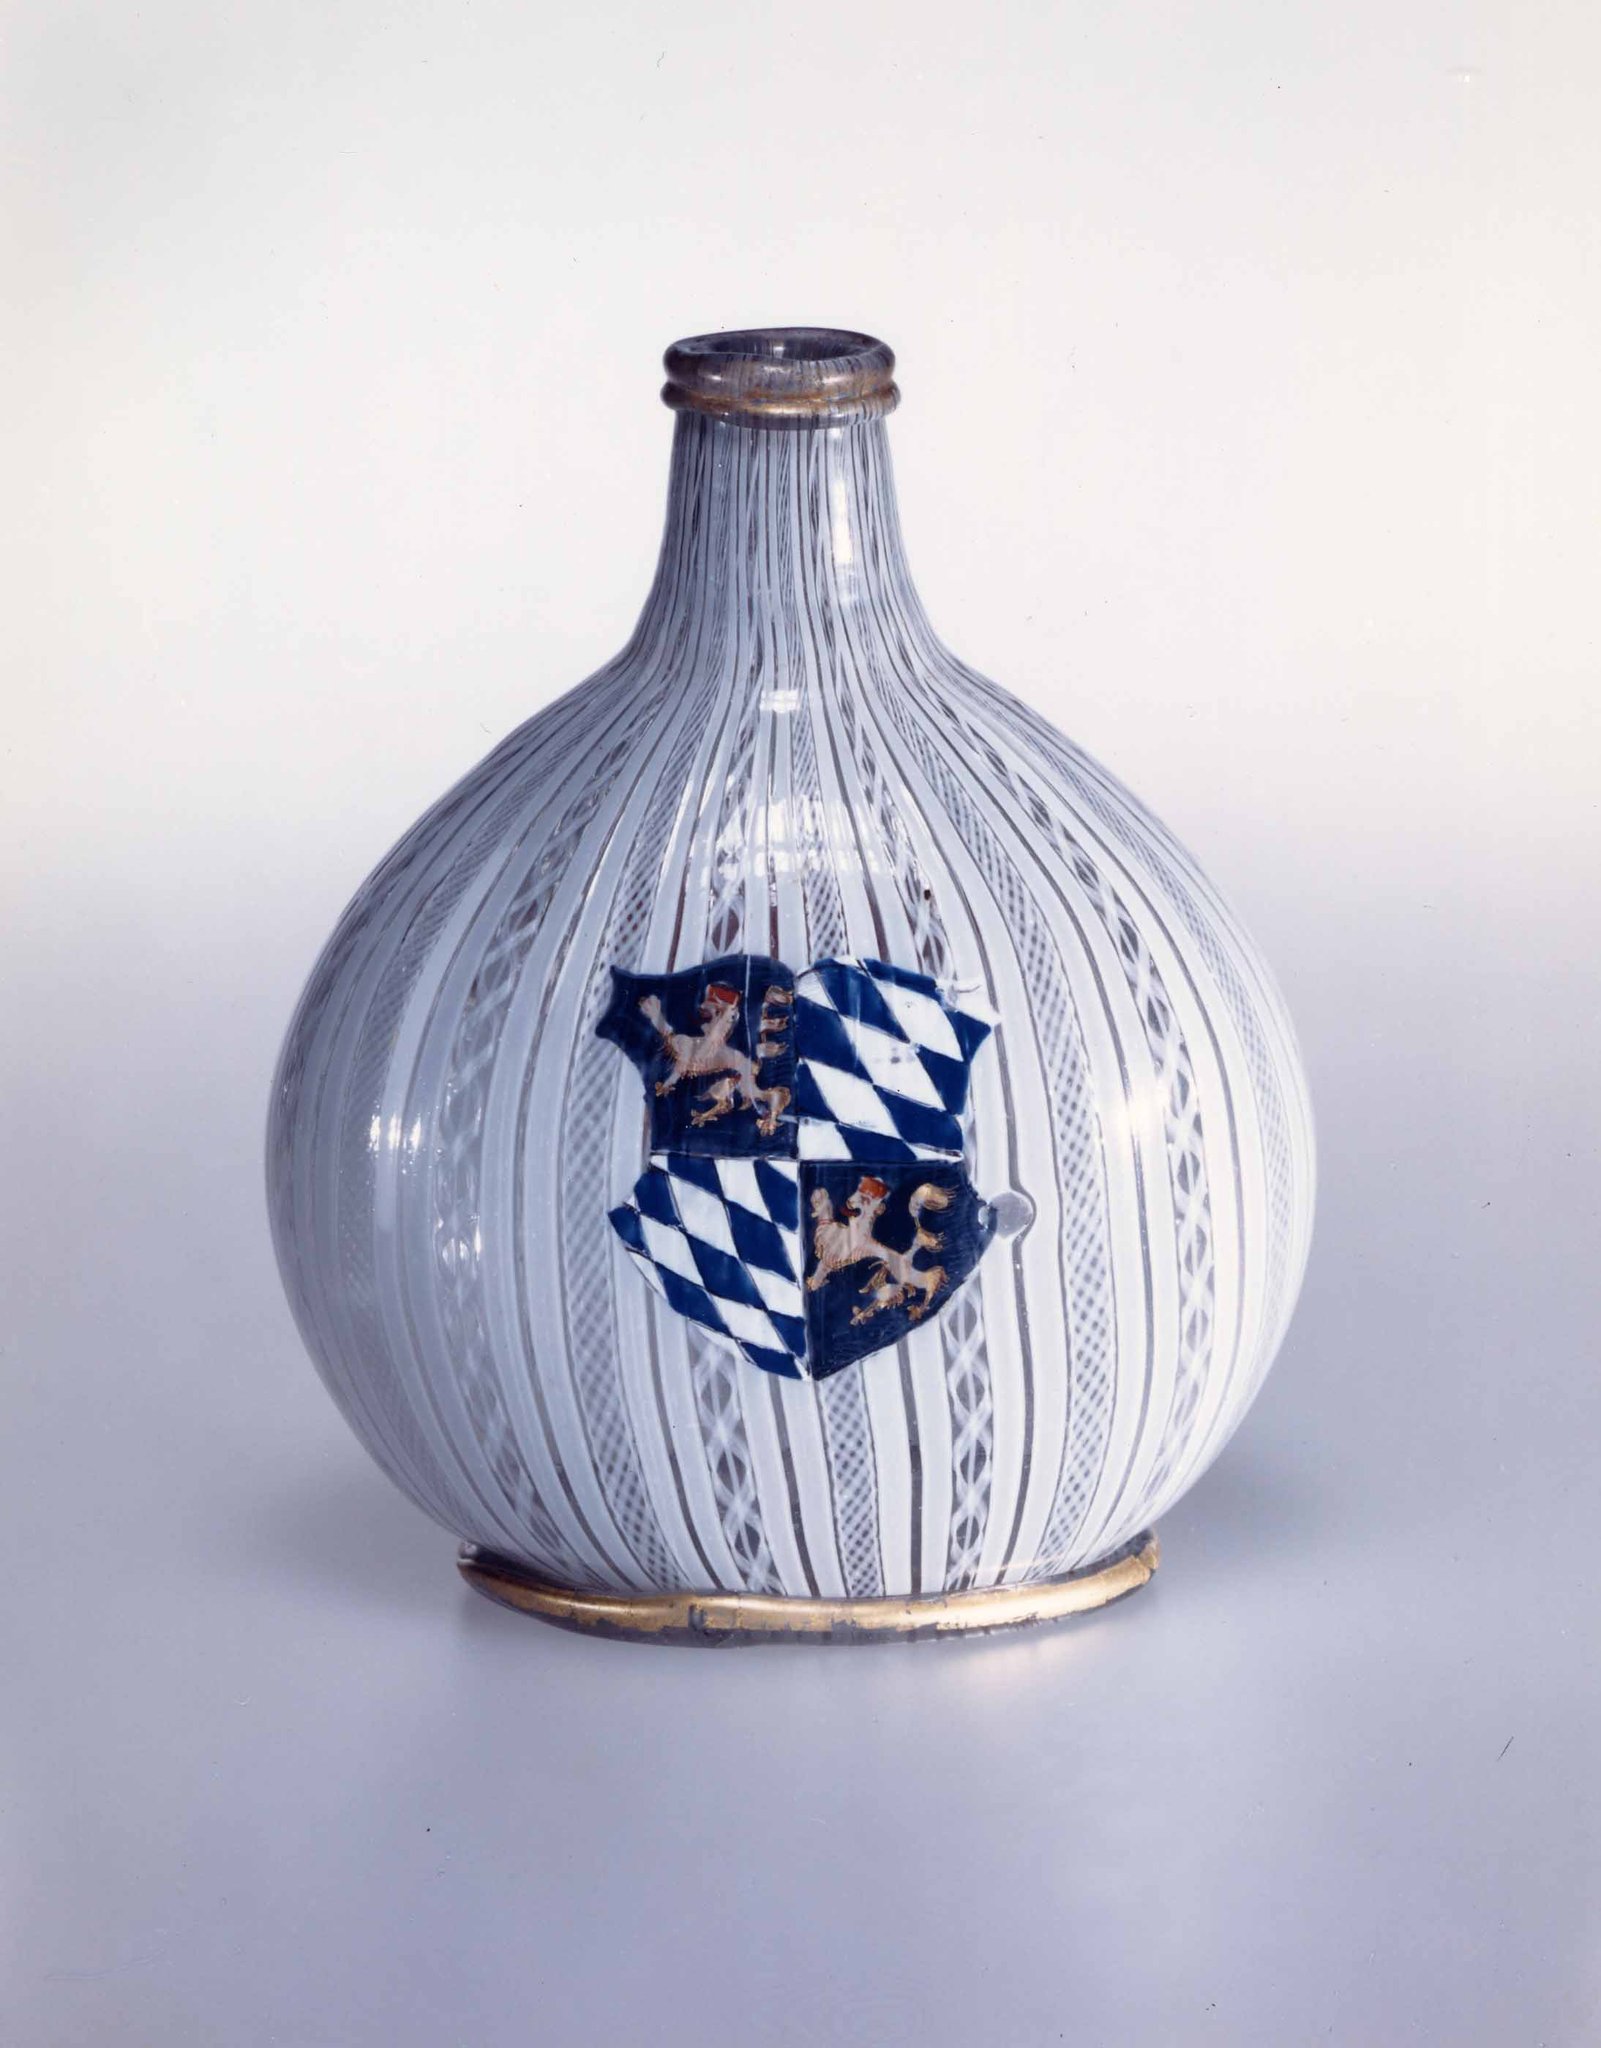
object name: flask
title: Armorial flask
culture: venetian or façon de venise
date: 1534-1566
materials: gilt, glass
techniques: glassblowing, enamel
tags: coat of arms